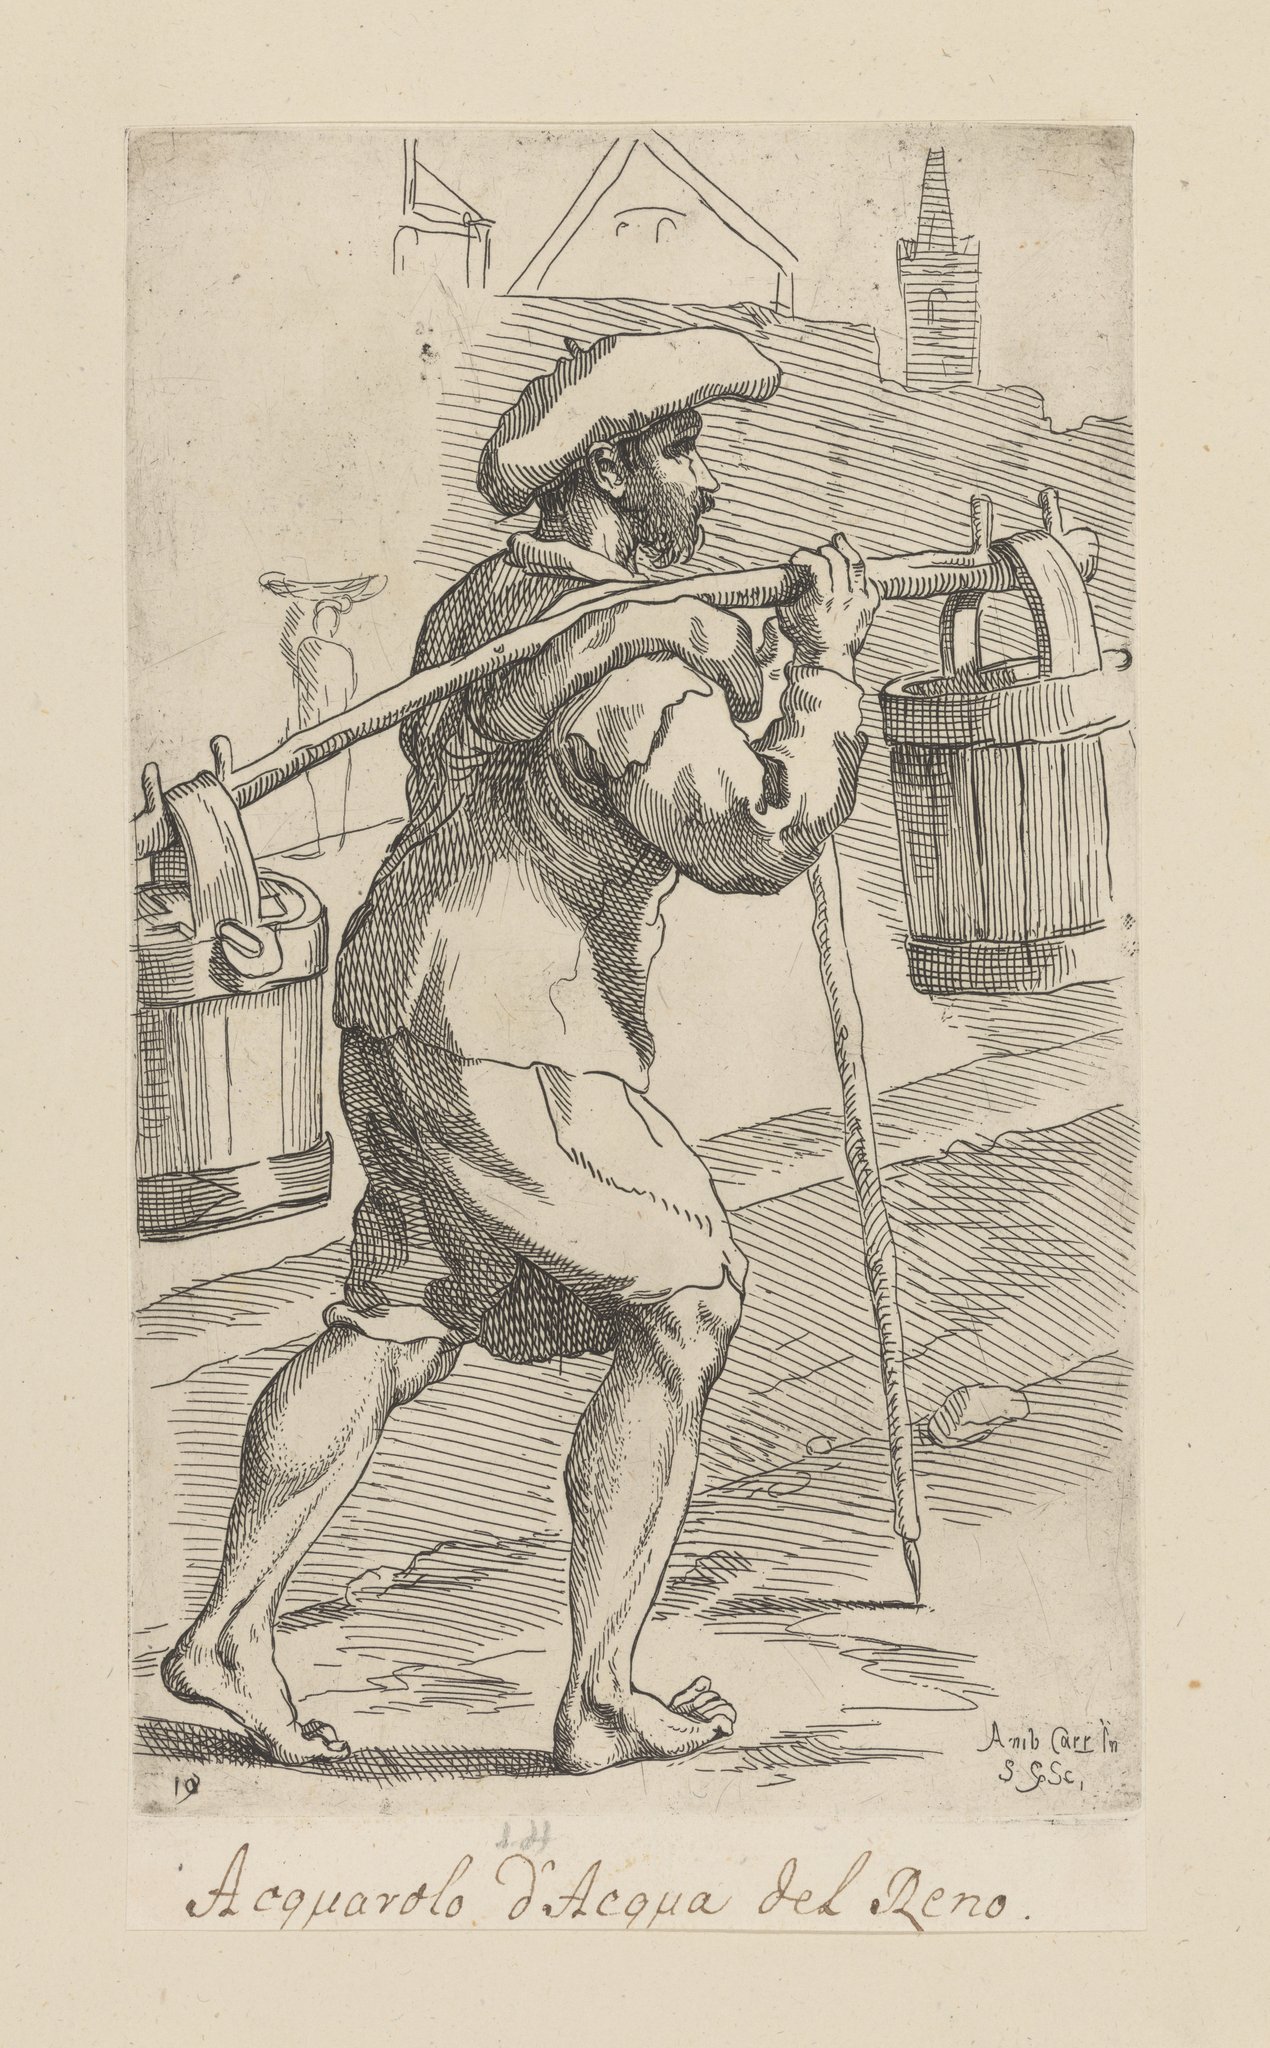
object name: print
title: Plate 10: Watercarrier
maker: simon guillain ii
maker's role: artist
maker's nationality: french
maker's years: 1618-1718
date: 1646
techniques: etching